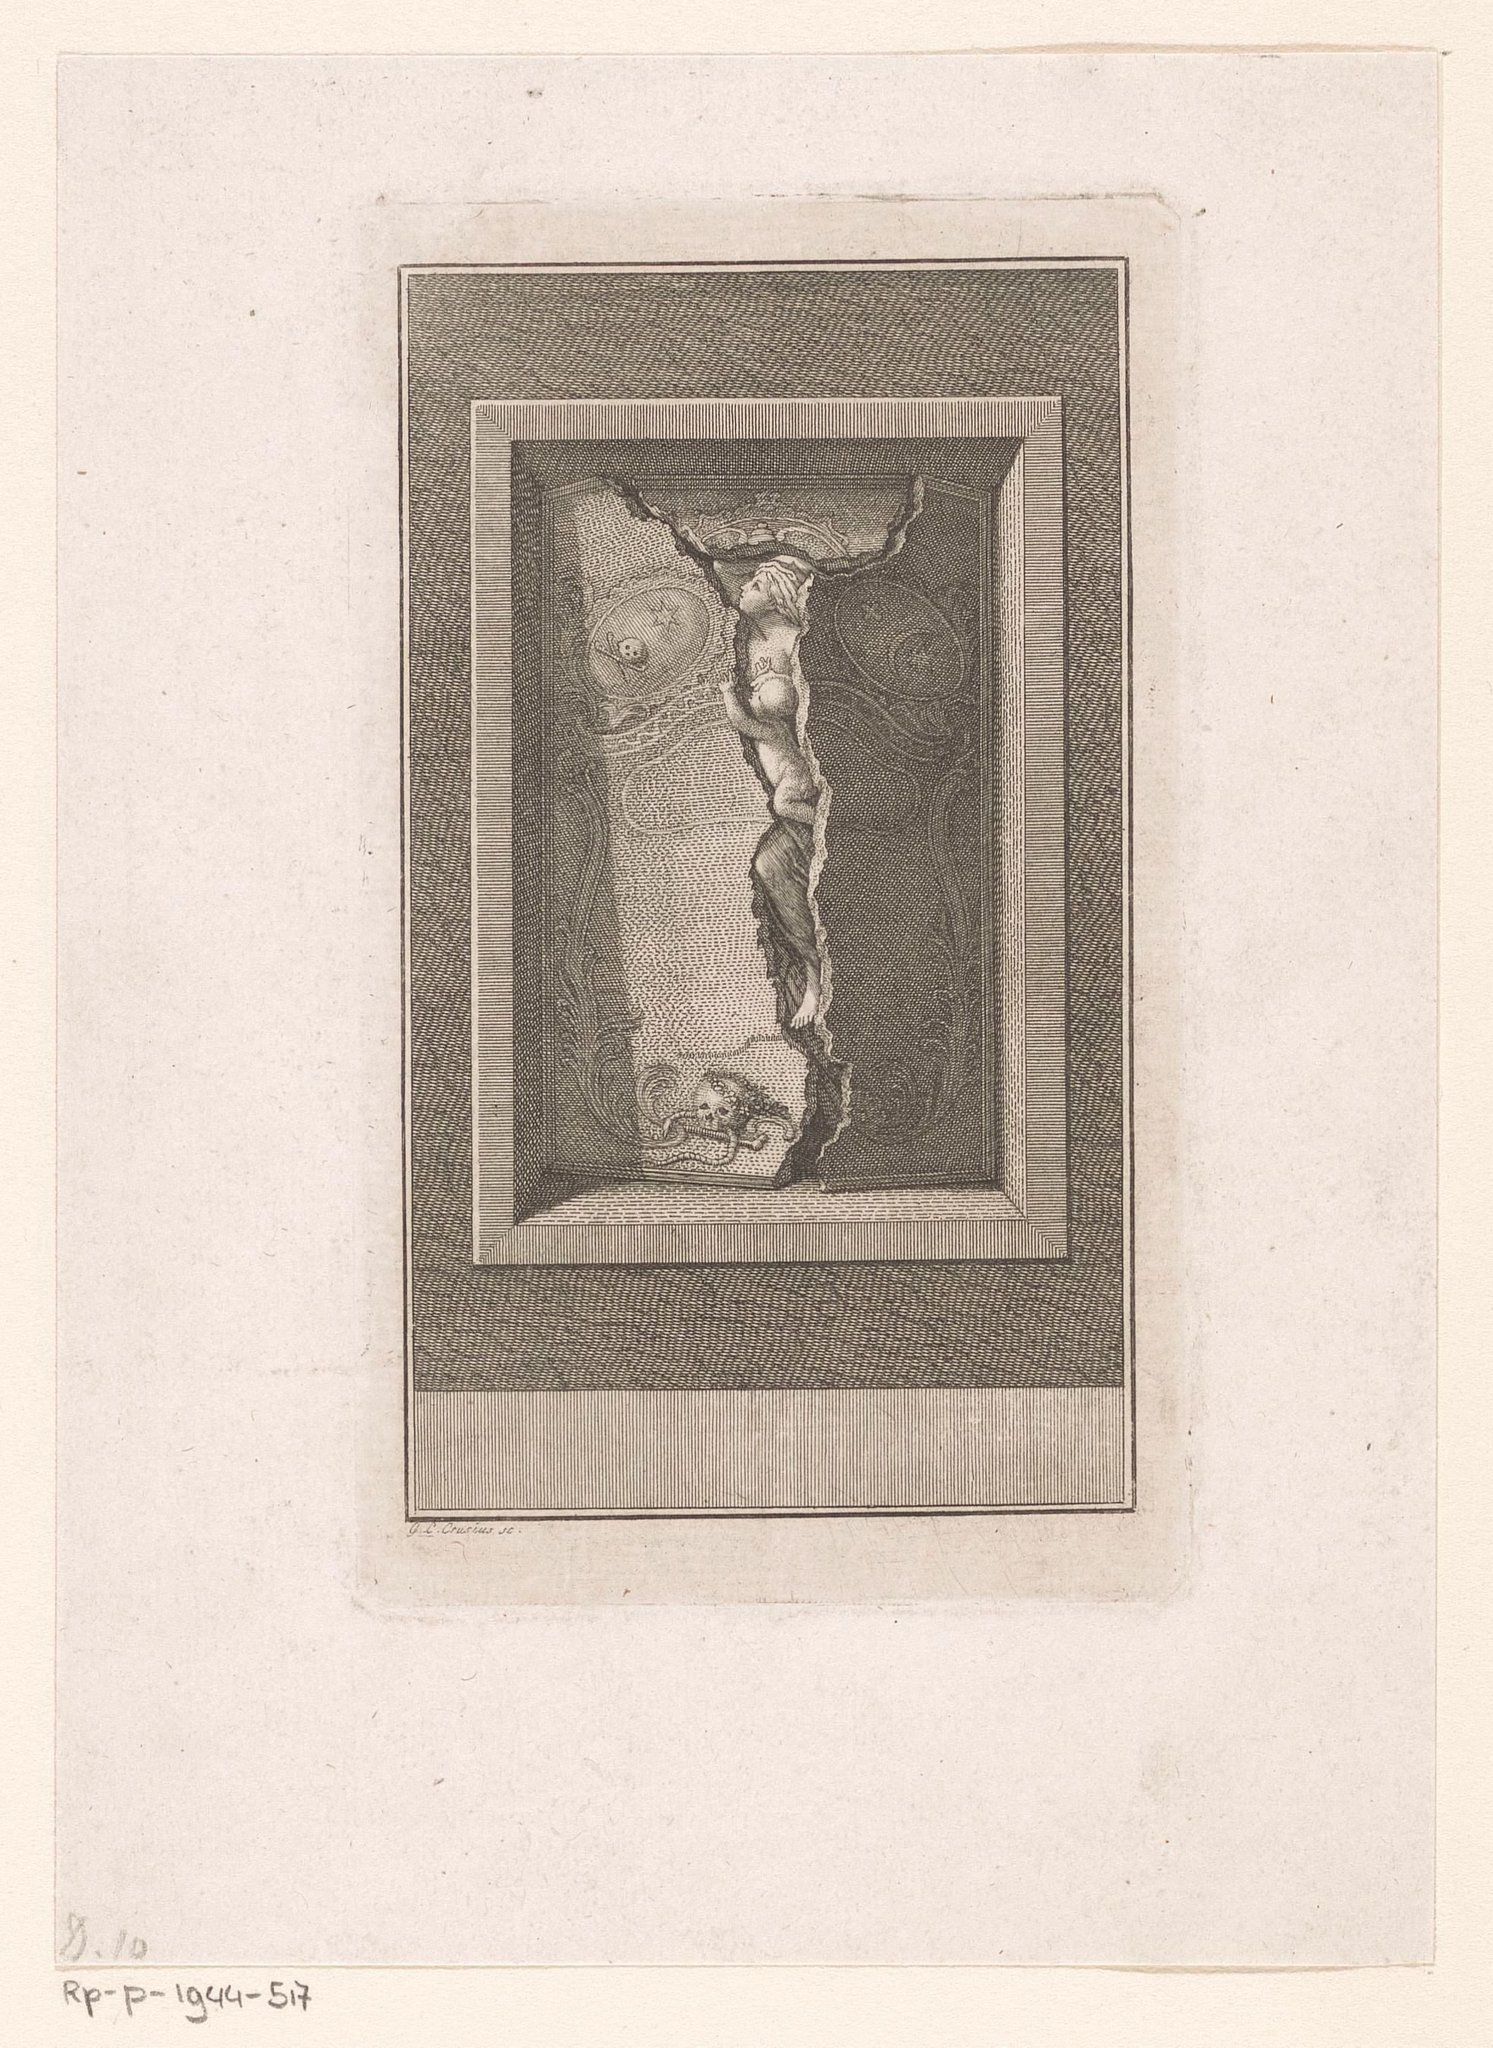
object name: print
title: Grafmonument van Maria Magdalena Langhans in de kerk van Hindelbank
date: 1751-1804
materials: paper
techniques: engraving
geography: bern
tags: 'vanitas' symbols, mother and baby or young child, stars, grave-building, monumental tomb, moon as celestial body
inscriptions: collector's mark: Lugt 2228